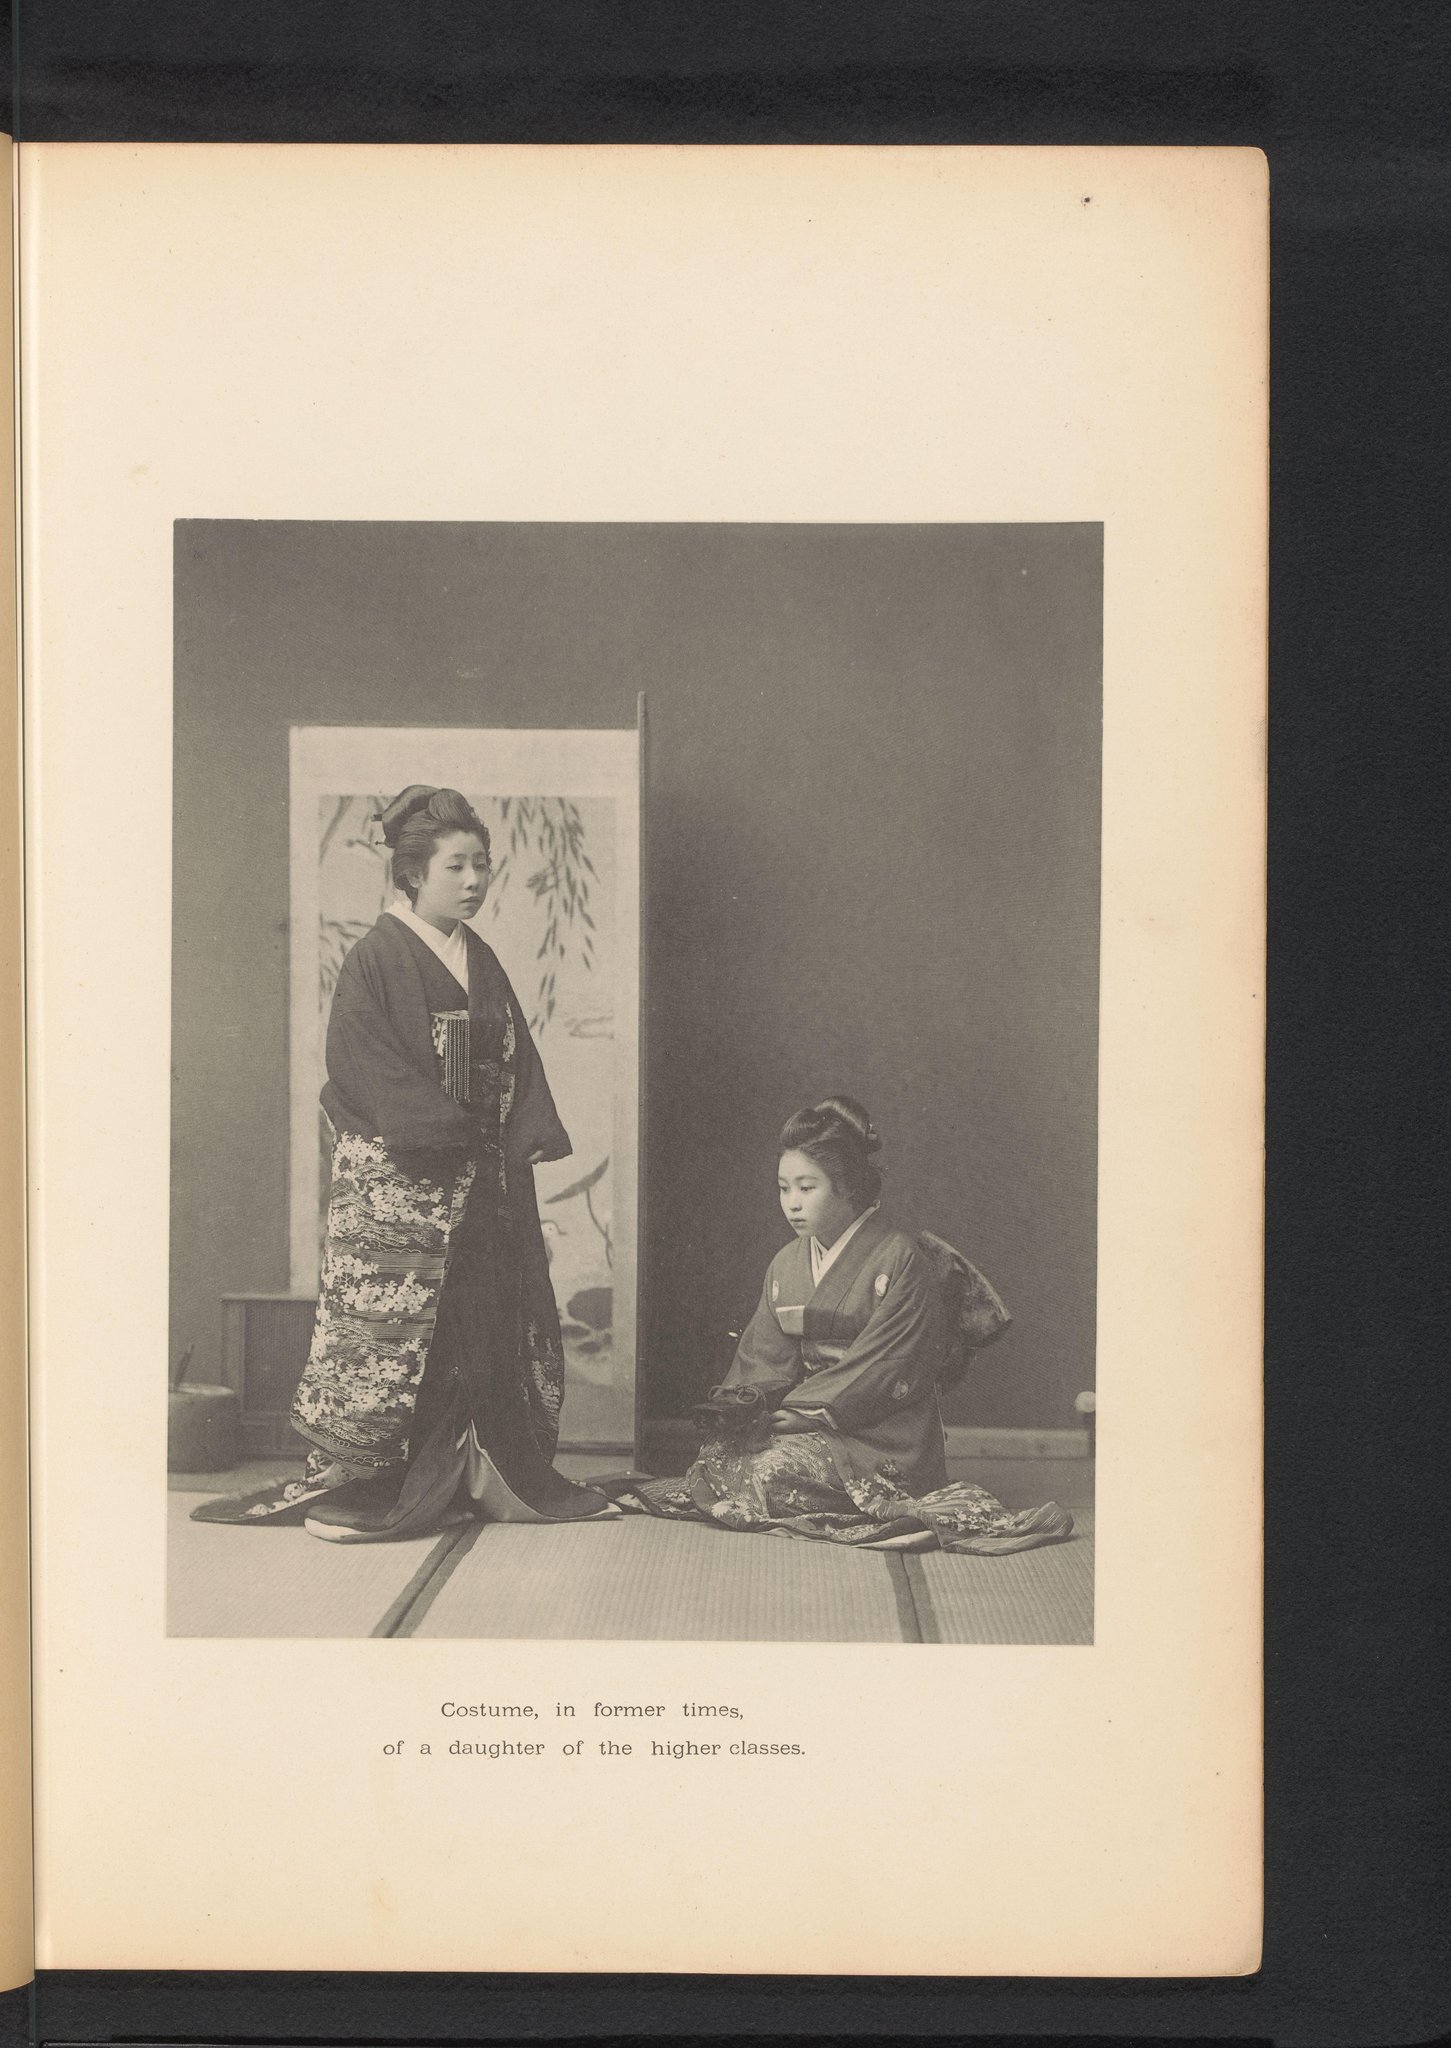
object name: page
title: Twee onbekende Japanse meisjes in traditionele kleding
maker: kazumasa ogawa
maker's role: auteur, fotograaf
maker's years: 1860-1929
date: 1890-1895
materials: paper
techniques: photograph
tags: adolescent, young woman, maiden, folk costume, regional costume